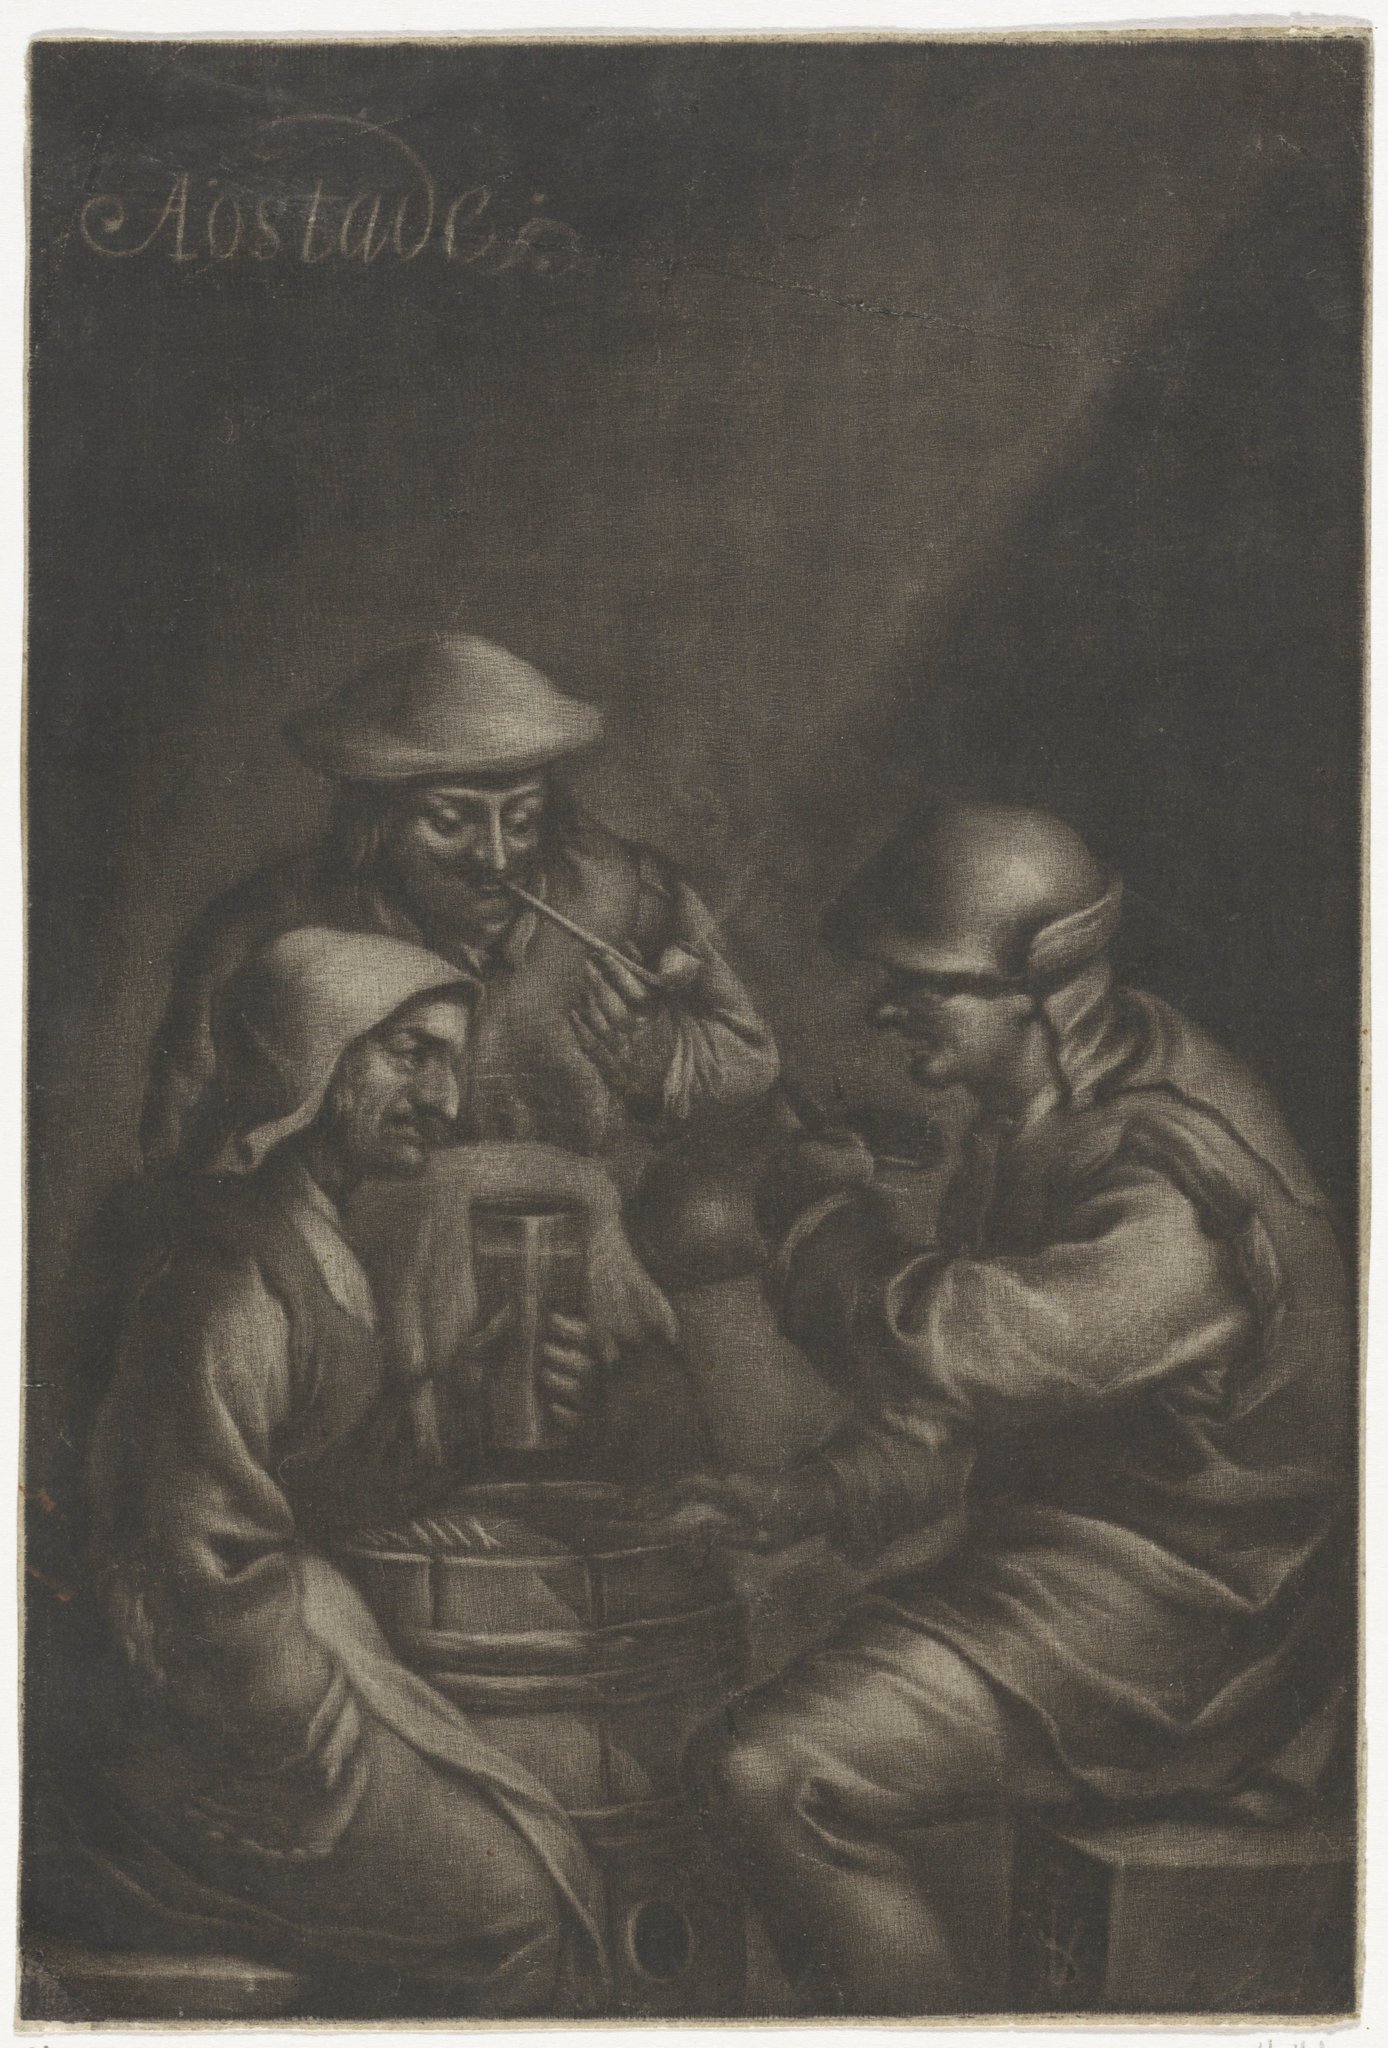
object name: print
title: Drie figuren drinken en roken rond een vat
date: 1655-1700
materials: paper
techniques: mezzotint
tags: wooden container: barrel, cask, bucket, tobacco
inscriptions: collector's mark: Lugt 2228